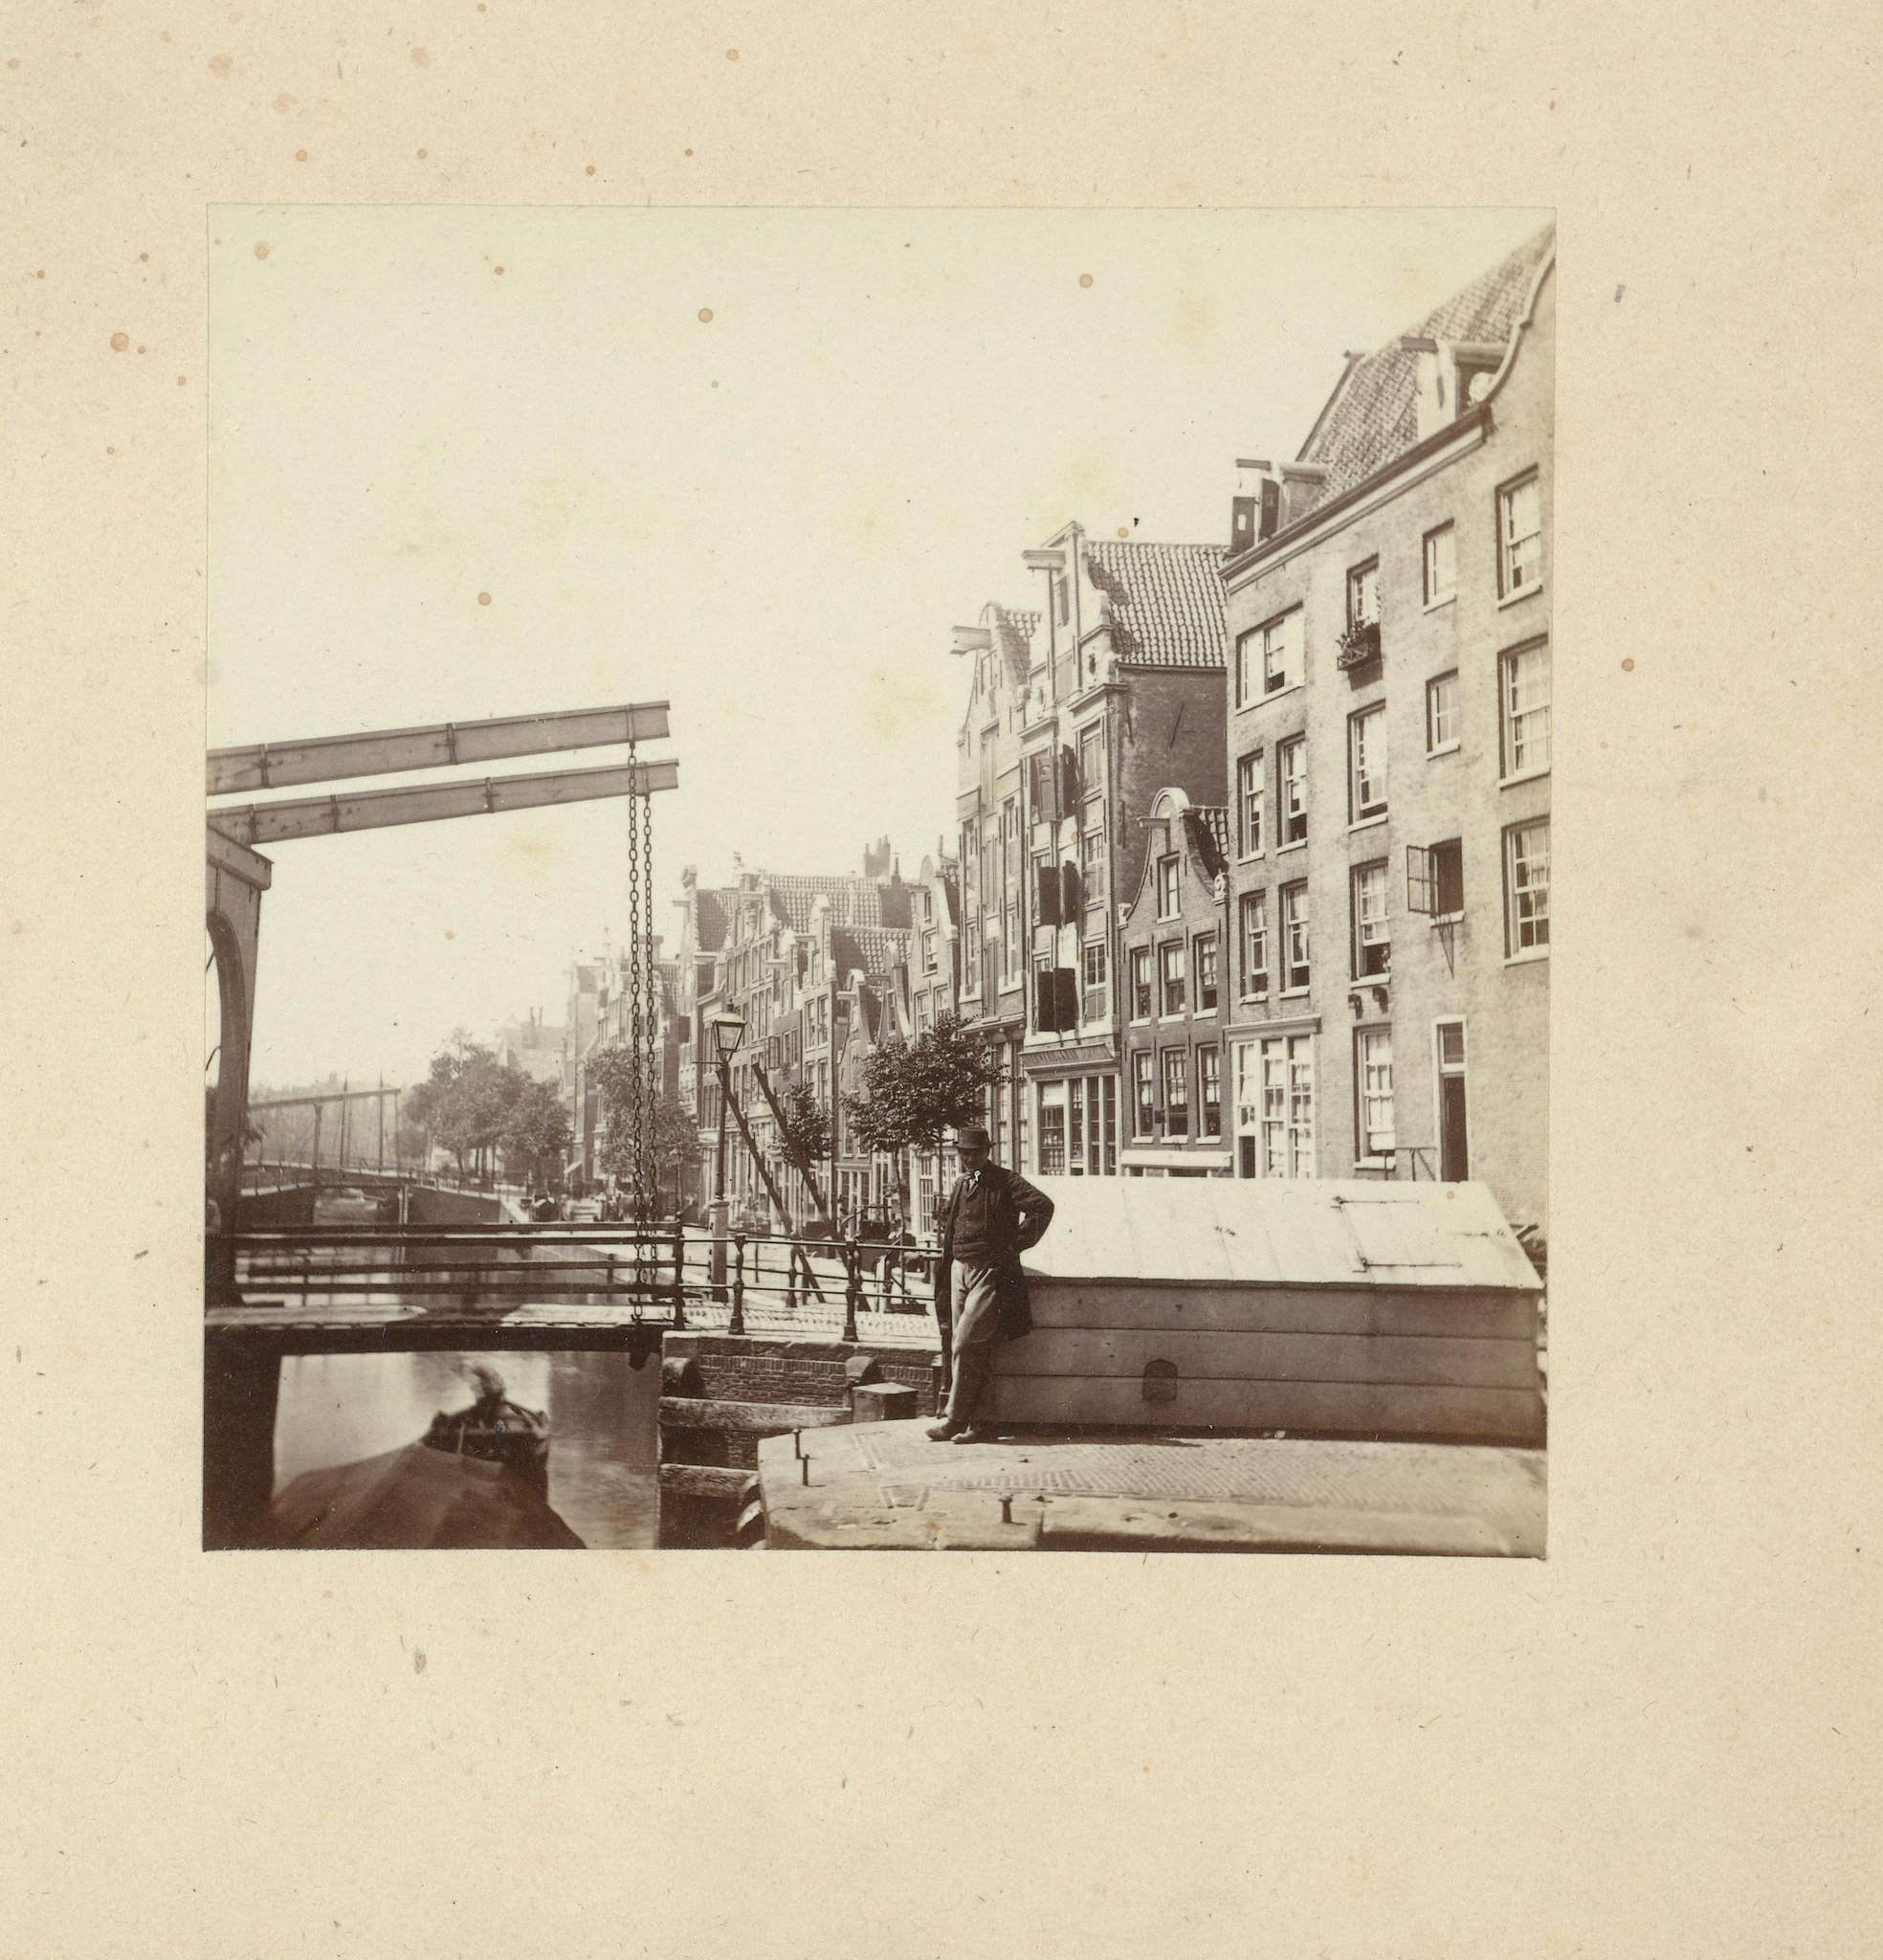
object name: photograph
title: Gezicht op de Brouwersgracht in Amsterdam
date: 1860-1875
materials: cardboard, paper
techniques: albumen print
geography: amsterdam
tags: bridge in city across river, canal, etc.